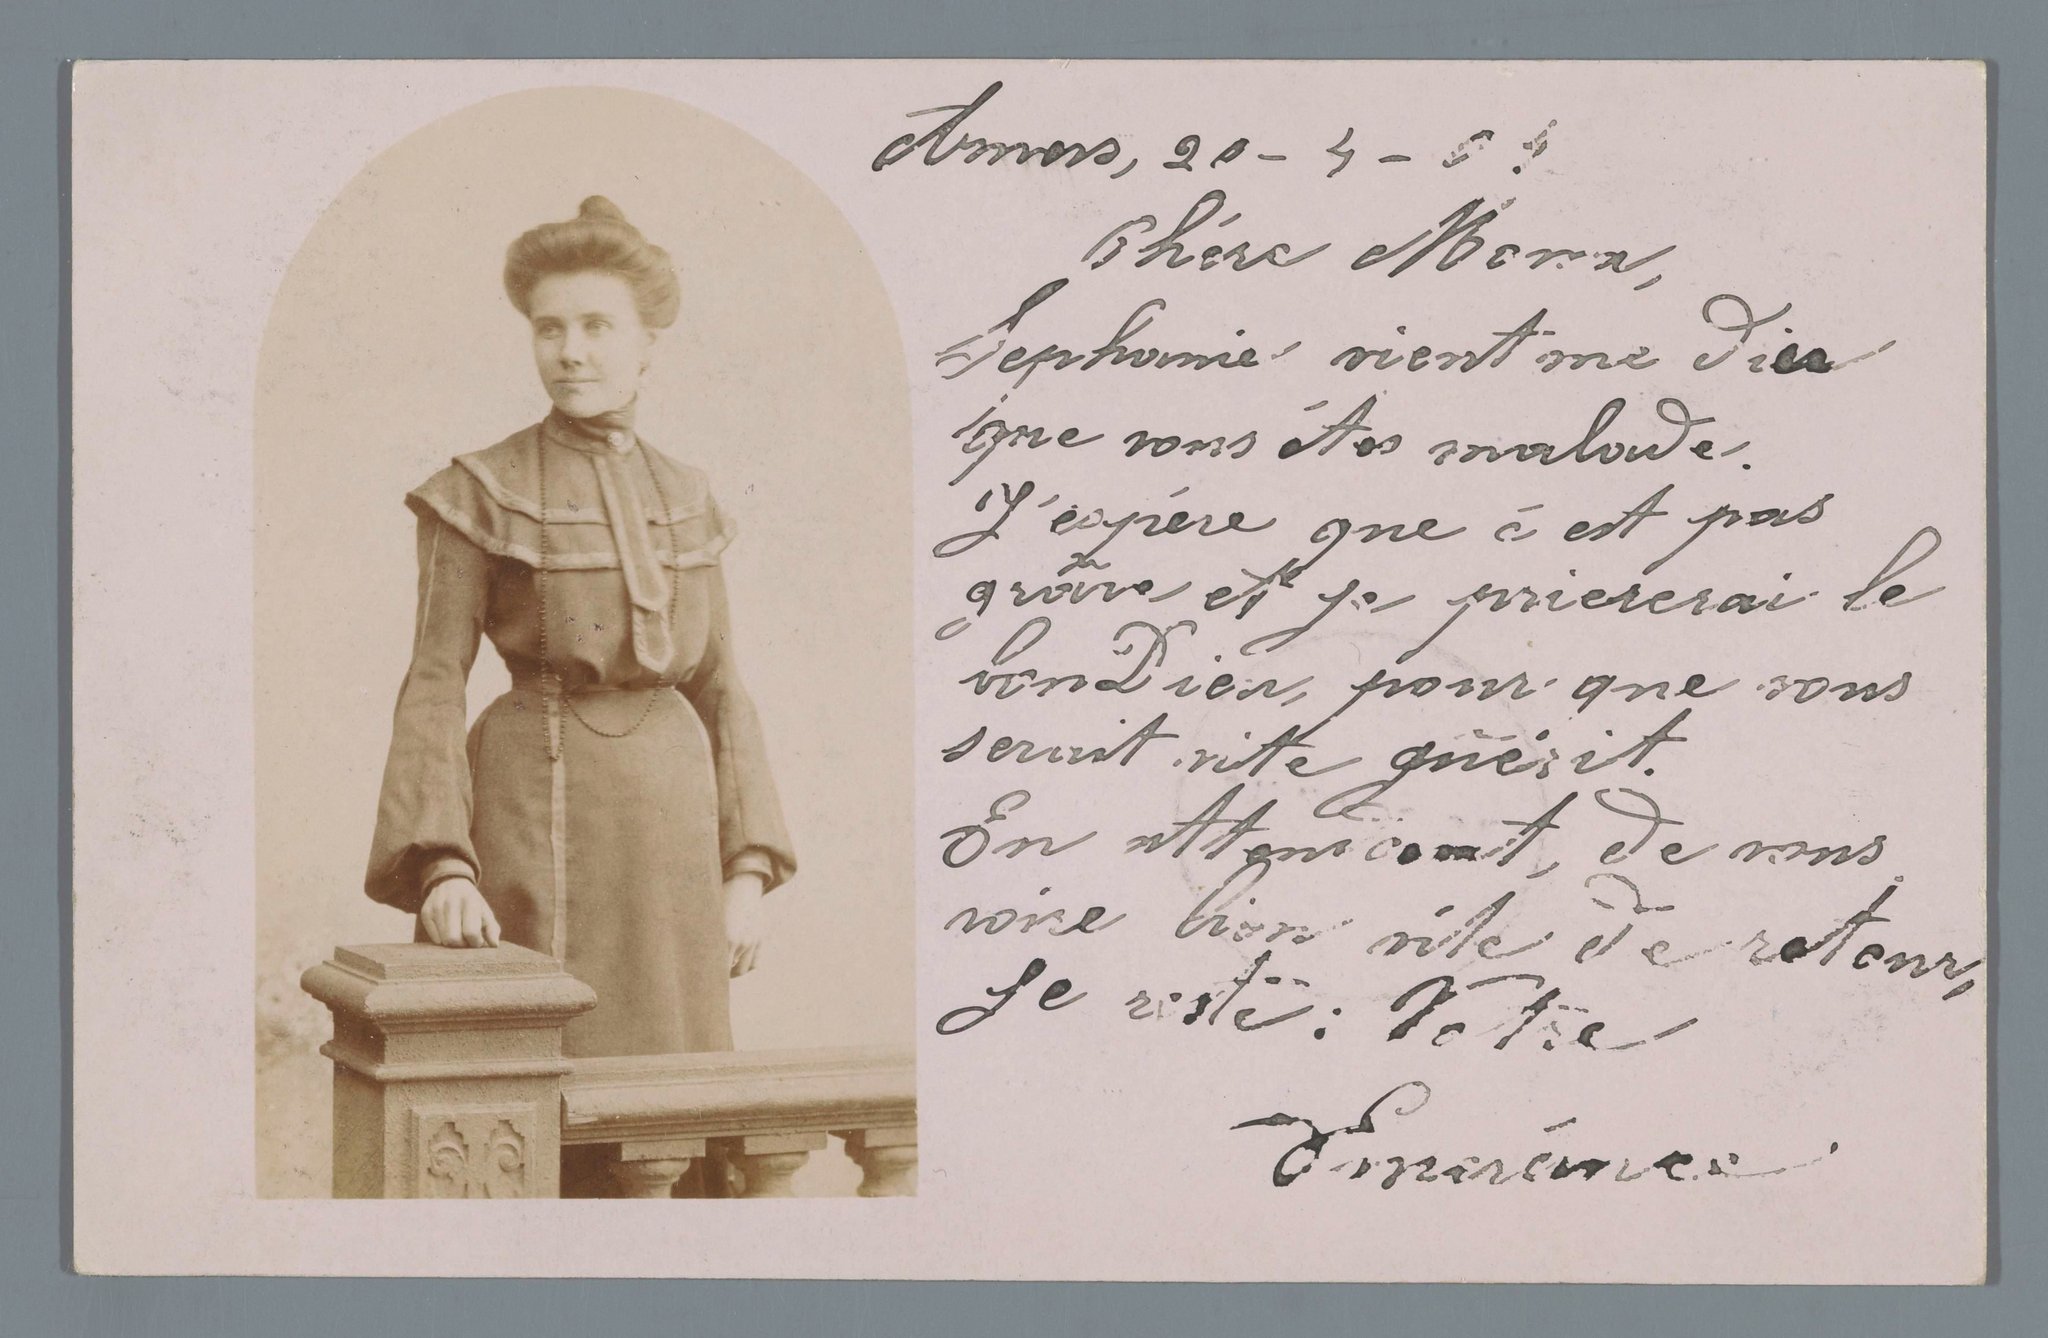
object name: ansichtkaart, prentbriefkaart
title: Portret van een onbekende vrouw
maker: Anonymous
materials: photographic support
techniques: daylight paper print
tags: adult woman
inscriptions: inscription: ‘Anvers, 20-4-04 (...) Emeré[...]’, inscription: ‘Mademoiselle Mona del'Arbre (...) Allemagne’, date: ‘21 Mai 1904’